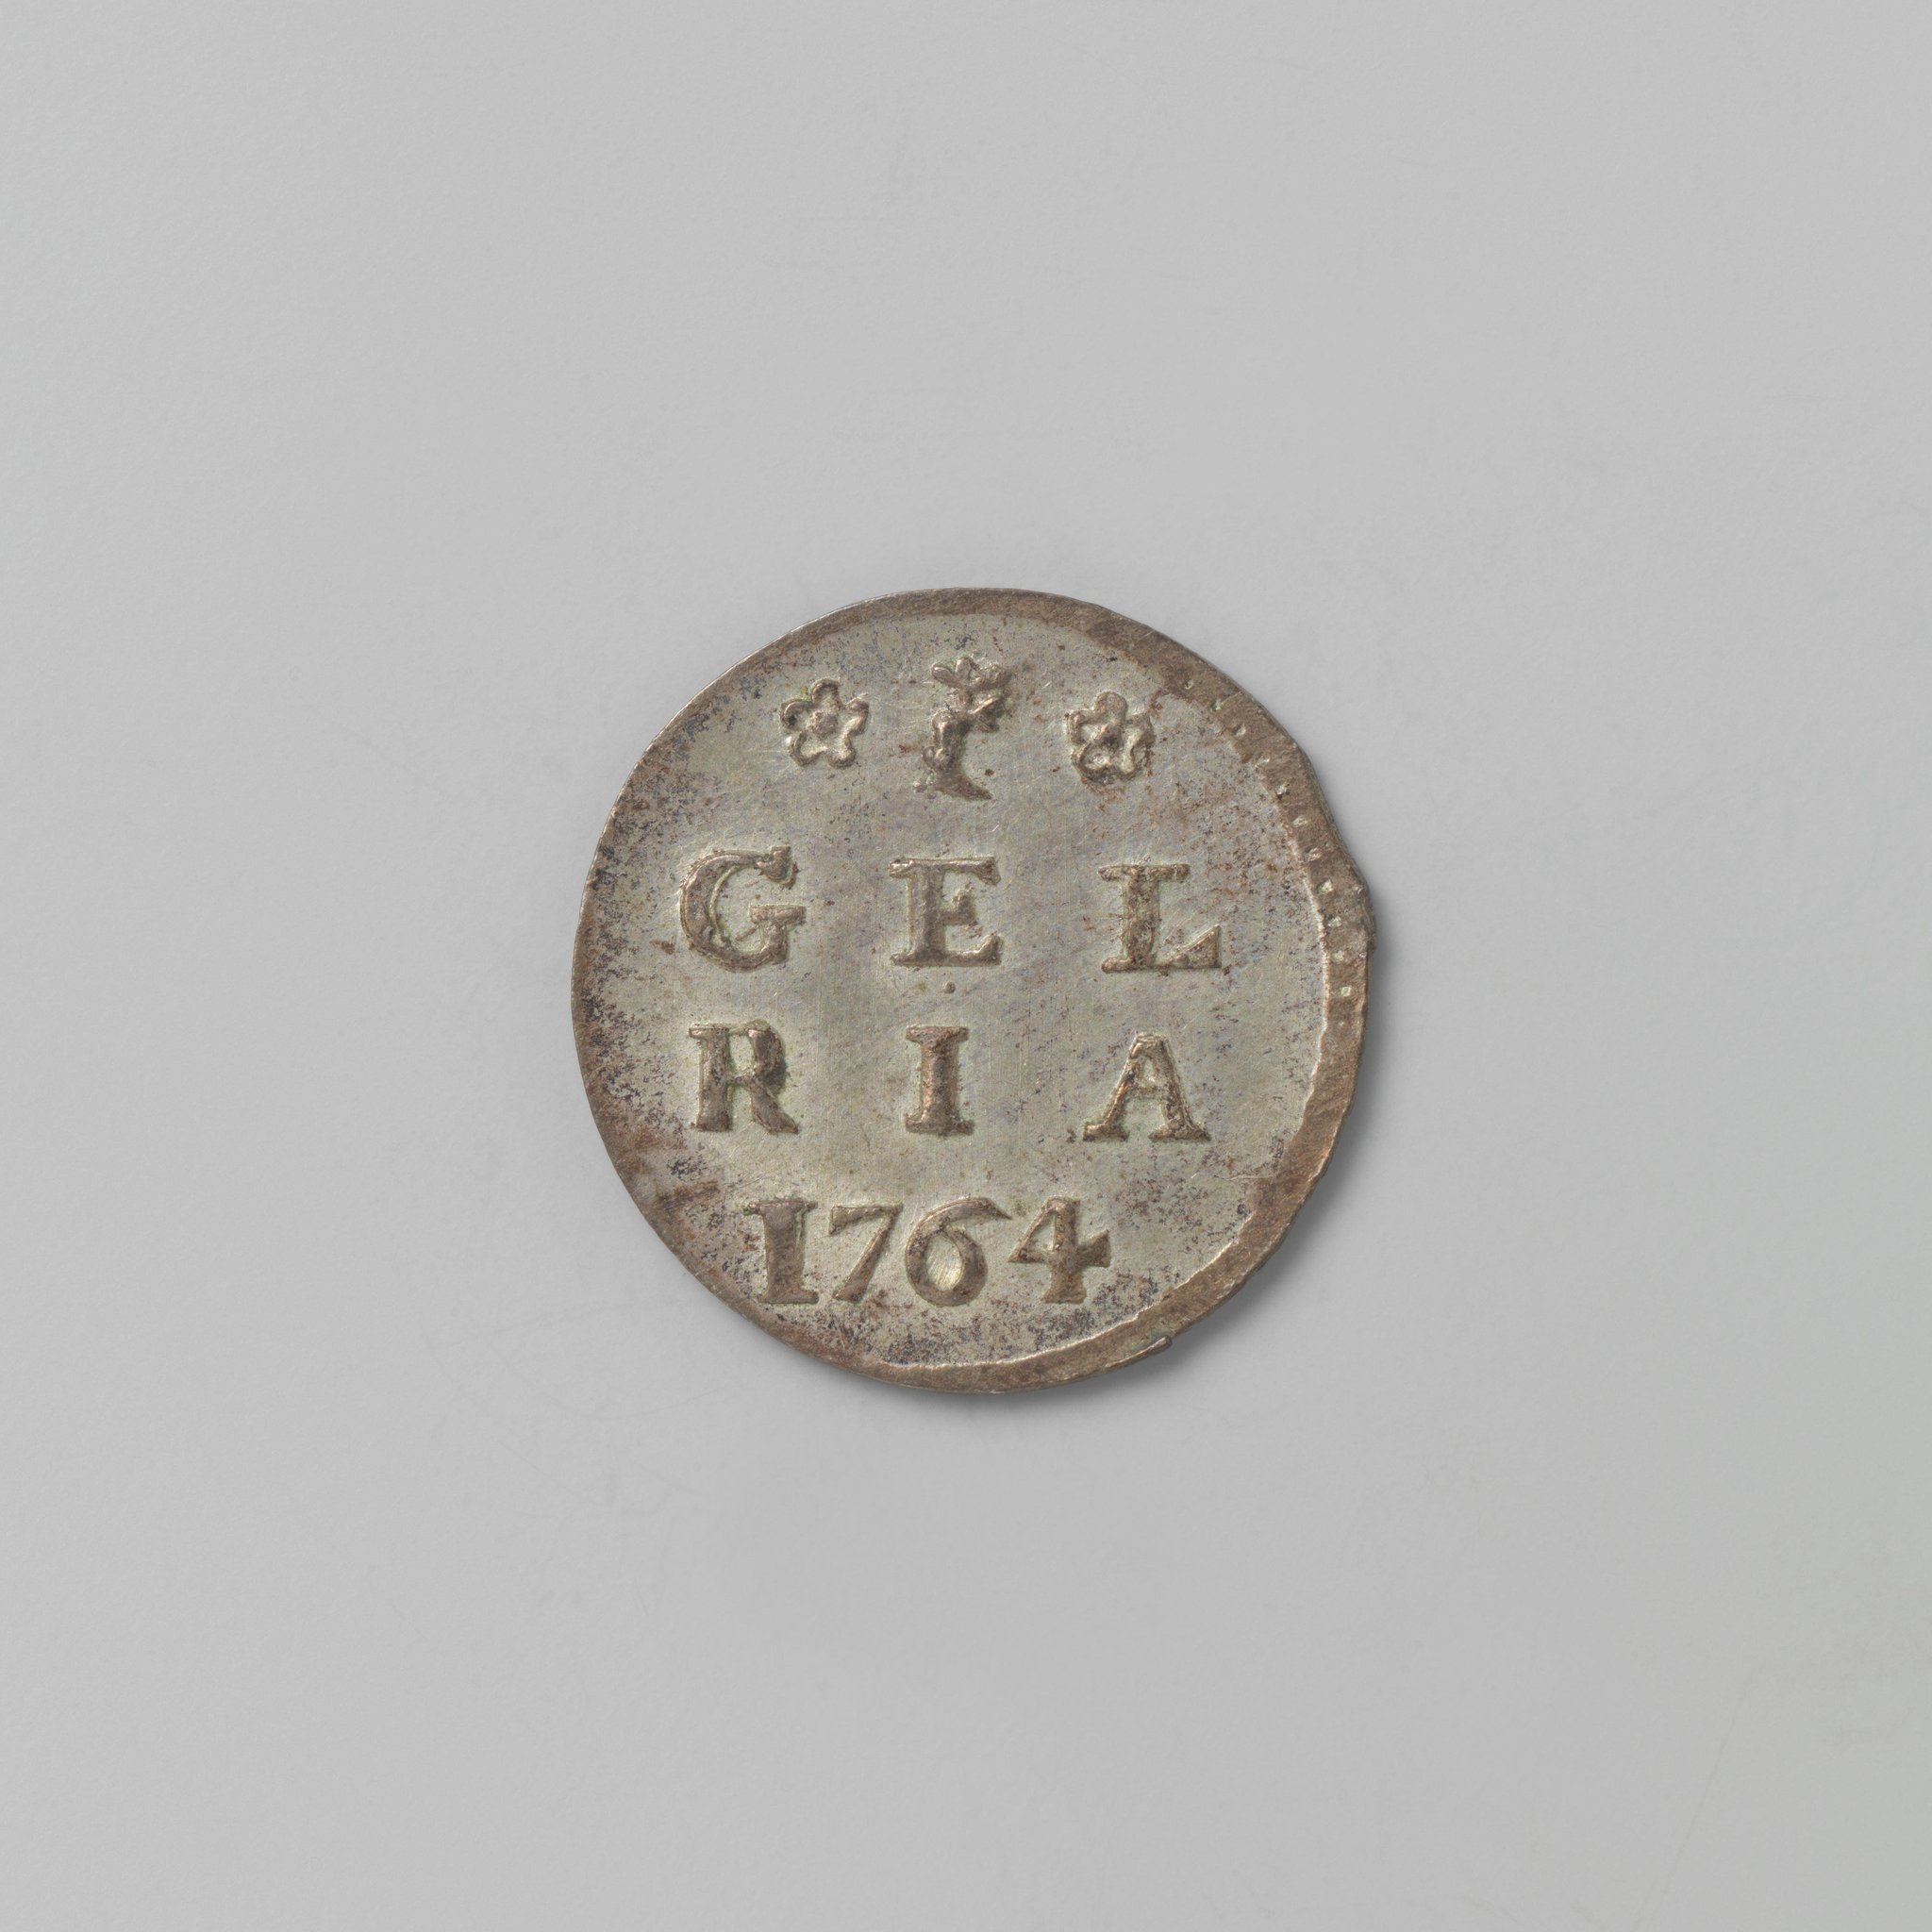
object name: coin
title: Gelderse stuiver, 1764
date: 1764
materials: silver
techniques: striking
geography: harderwijk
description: Zilveren munt. Voorzijde: in twee regels GEL/RIA, daaronder jaartal, daarboven muntmeesterteken. Keerzijde: binnen lauwerkrans tussen waarde-aanduiding pijlenbundel.